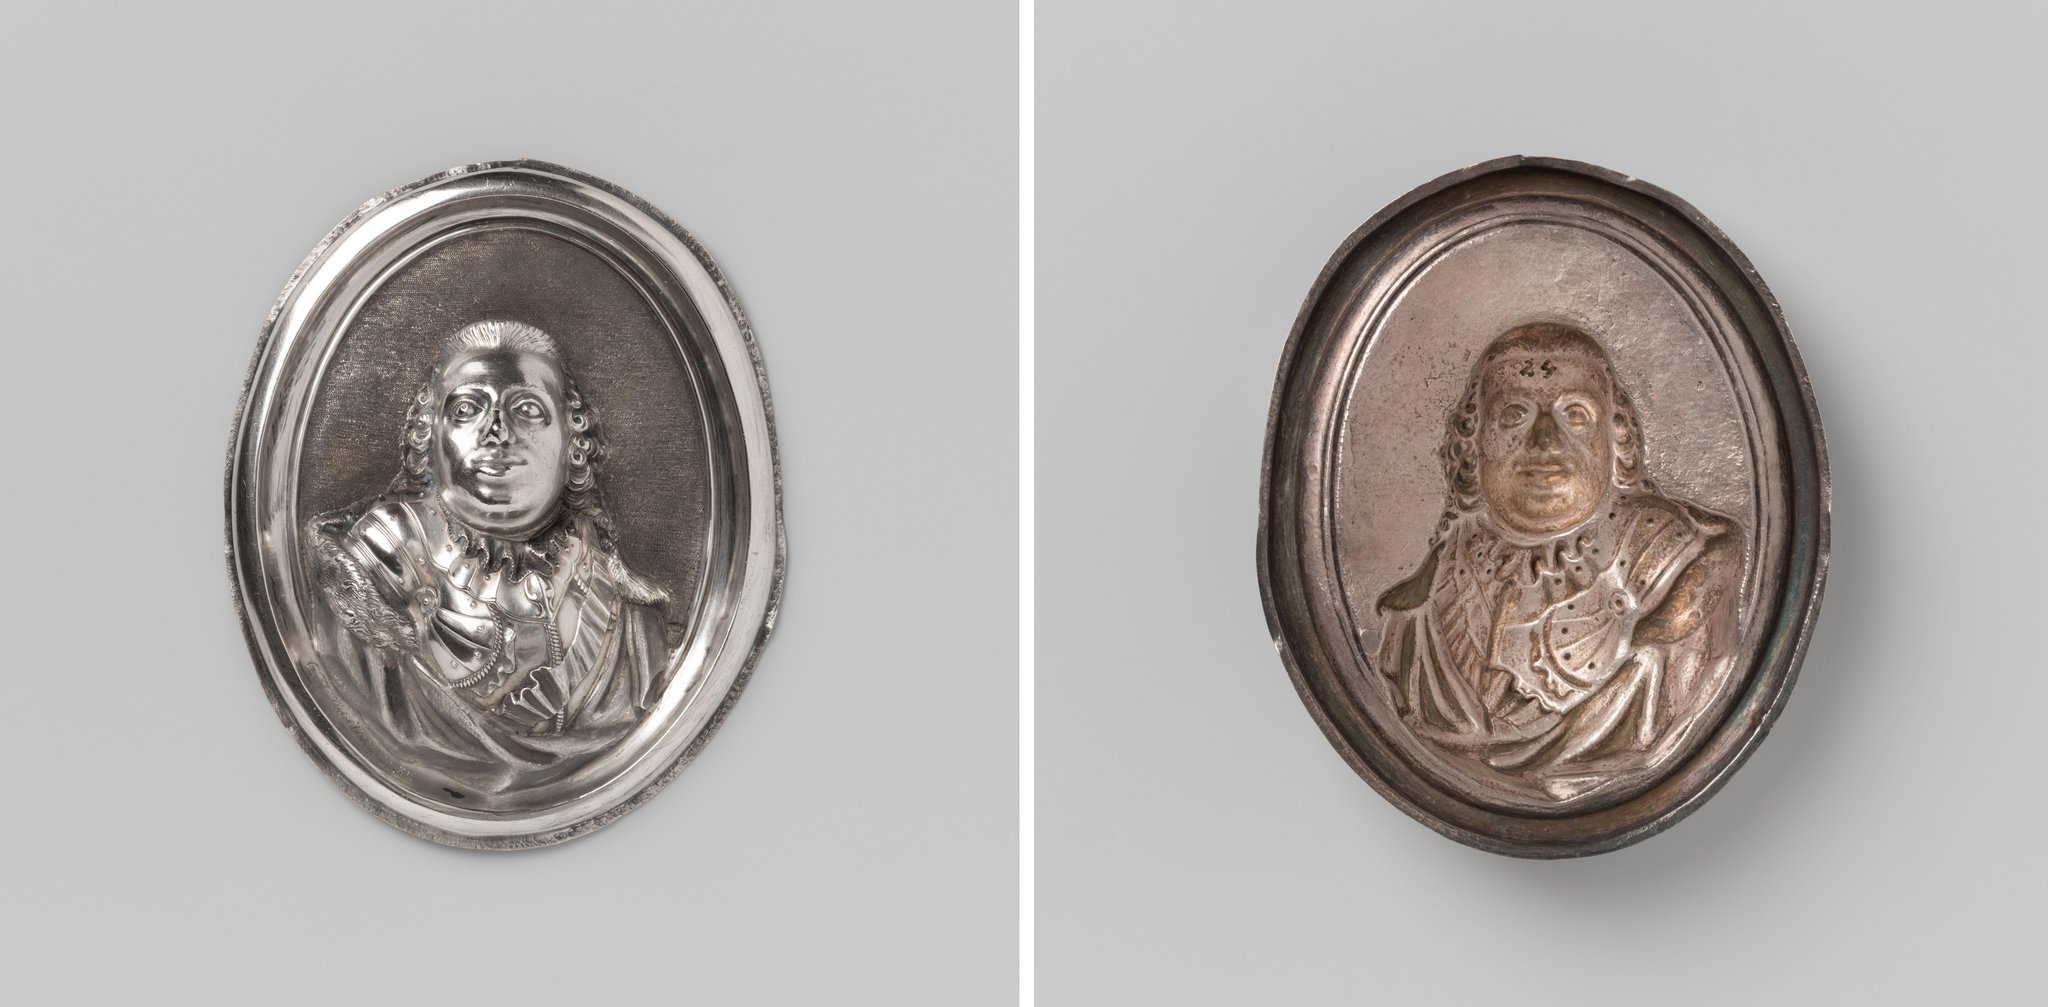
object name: plaque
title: Willem IV, prins van Oranje-Nassau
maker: gerrit van moelingen (i)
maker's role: medailleur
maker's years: 1711-1773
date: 1748-1751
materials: metal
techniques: casting, engraving, silvering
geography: the hague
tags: willem iv (prins van oranje-nassau)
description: Eenzijdige, ovale plaquette. Voorzijde: borststuk man in harnas en hermelijnen mantel; rechts tegen rand: gekroond wapenschildje. Keerzijde: blanco.